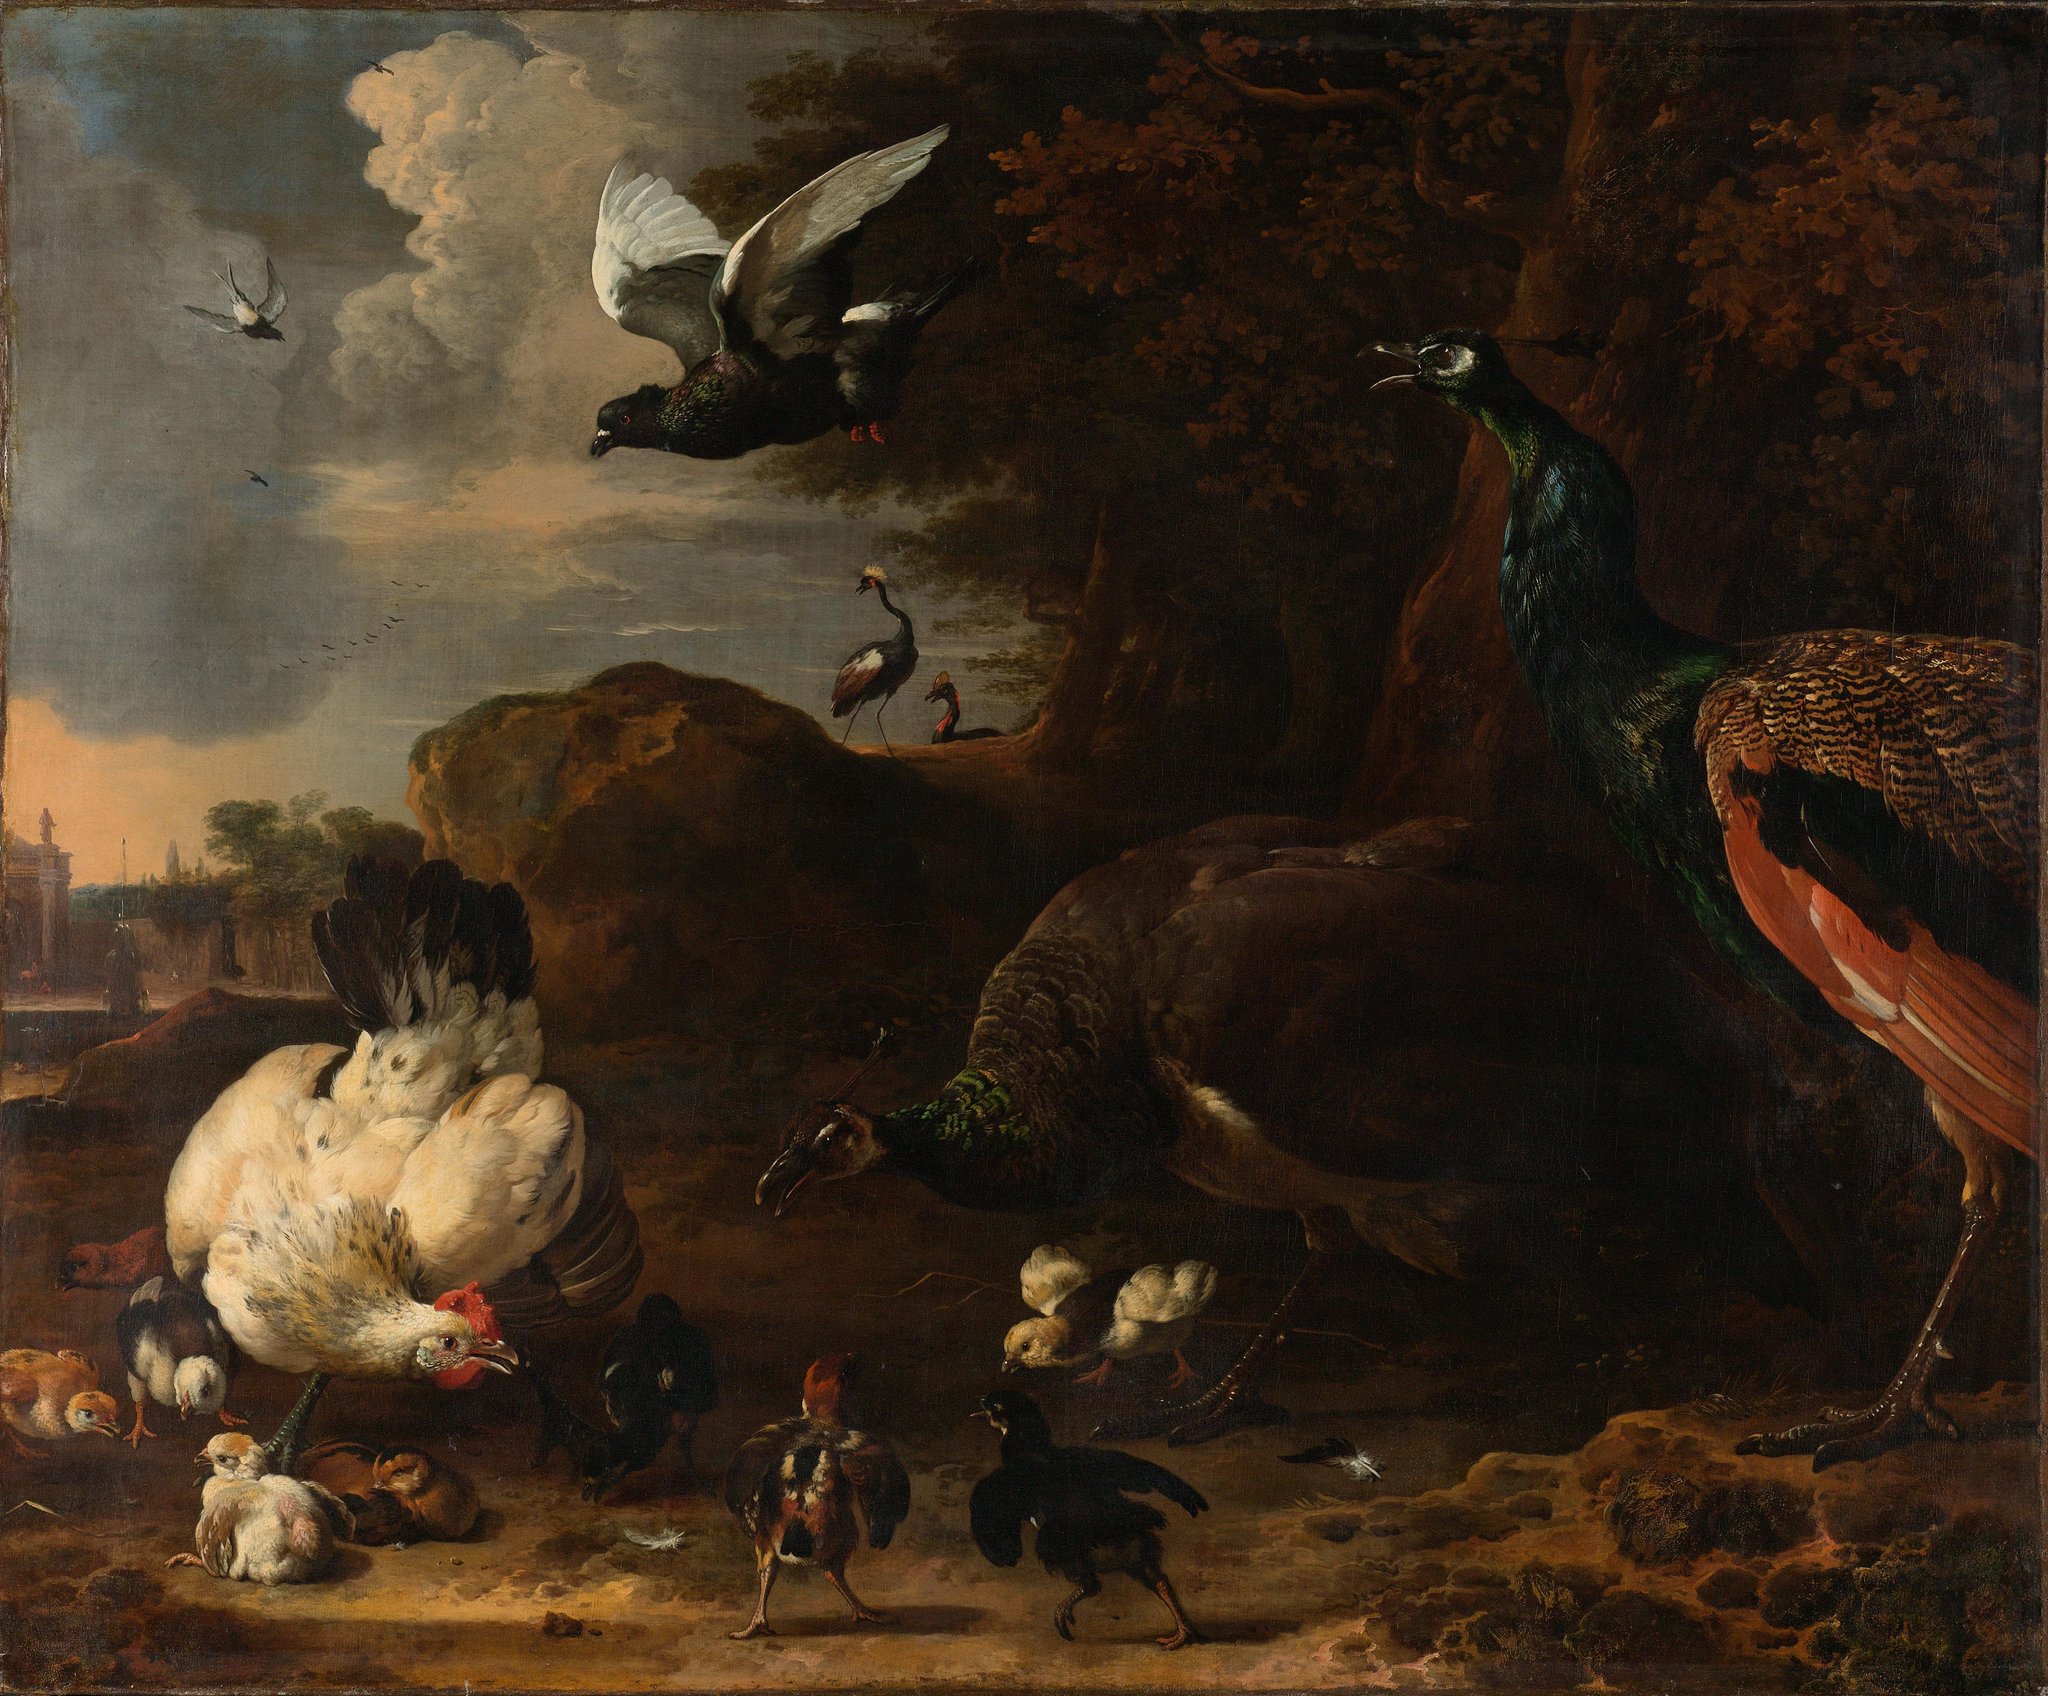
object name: painting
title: Two Peacocks Threatening a Hen with Chicks, known as 'The Threatened Hen'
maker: melchior d hondecoeter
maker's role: draughtsman, painter, print maker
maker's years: 1636-1695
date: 1681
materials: canvas, oil, paint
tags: shore-birds and wading-birds: black-crowned crane, ornamental birds: peacock, fowl (cock, hen, chicken, etc.)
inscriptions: signature and date: ‘M. d Hondecoeter Aº 1681’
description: Hondecoeter enlivened his bird paintings with little vignettes. Here the focus is on the hen protecting her chicks from the large and intimidating peacocks.